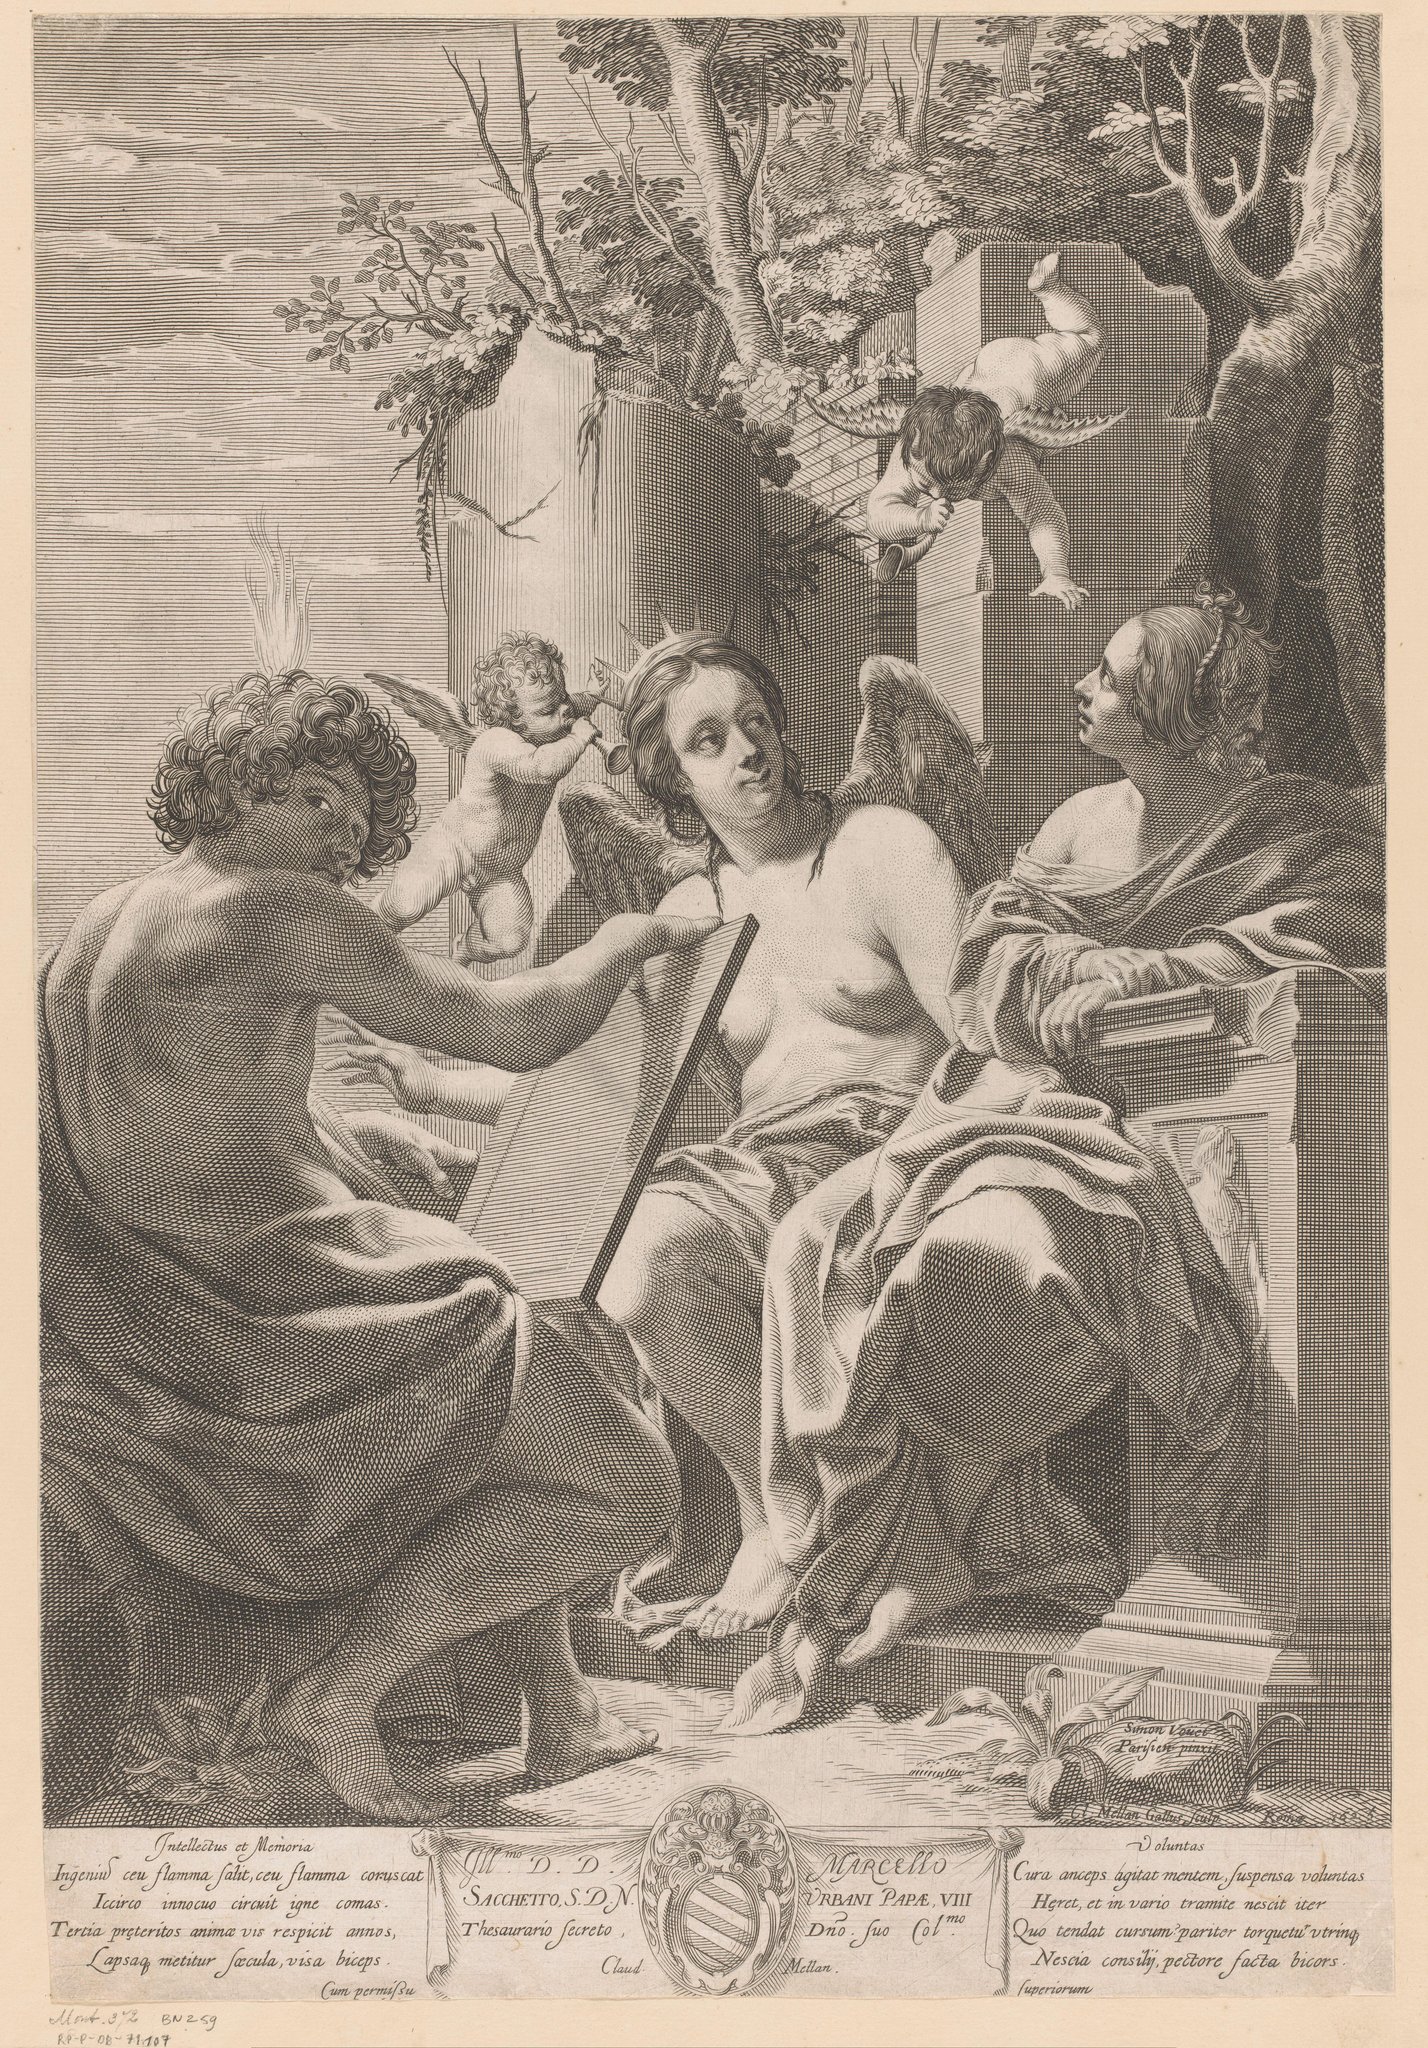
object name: print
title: Intelligentia, Herinnering en Wilskracht bij ruïnes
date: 1625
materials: paper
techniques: engraving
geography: italy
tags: intellect, intelligence; 'intelletto', 'intelligenza' (ripa), forethought, deliberation; 'previdenza', 'providenza' (ripa), memory; 'memoria' (ripa)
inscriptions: collector's mark: Lugt 240